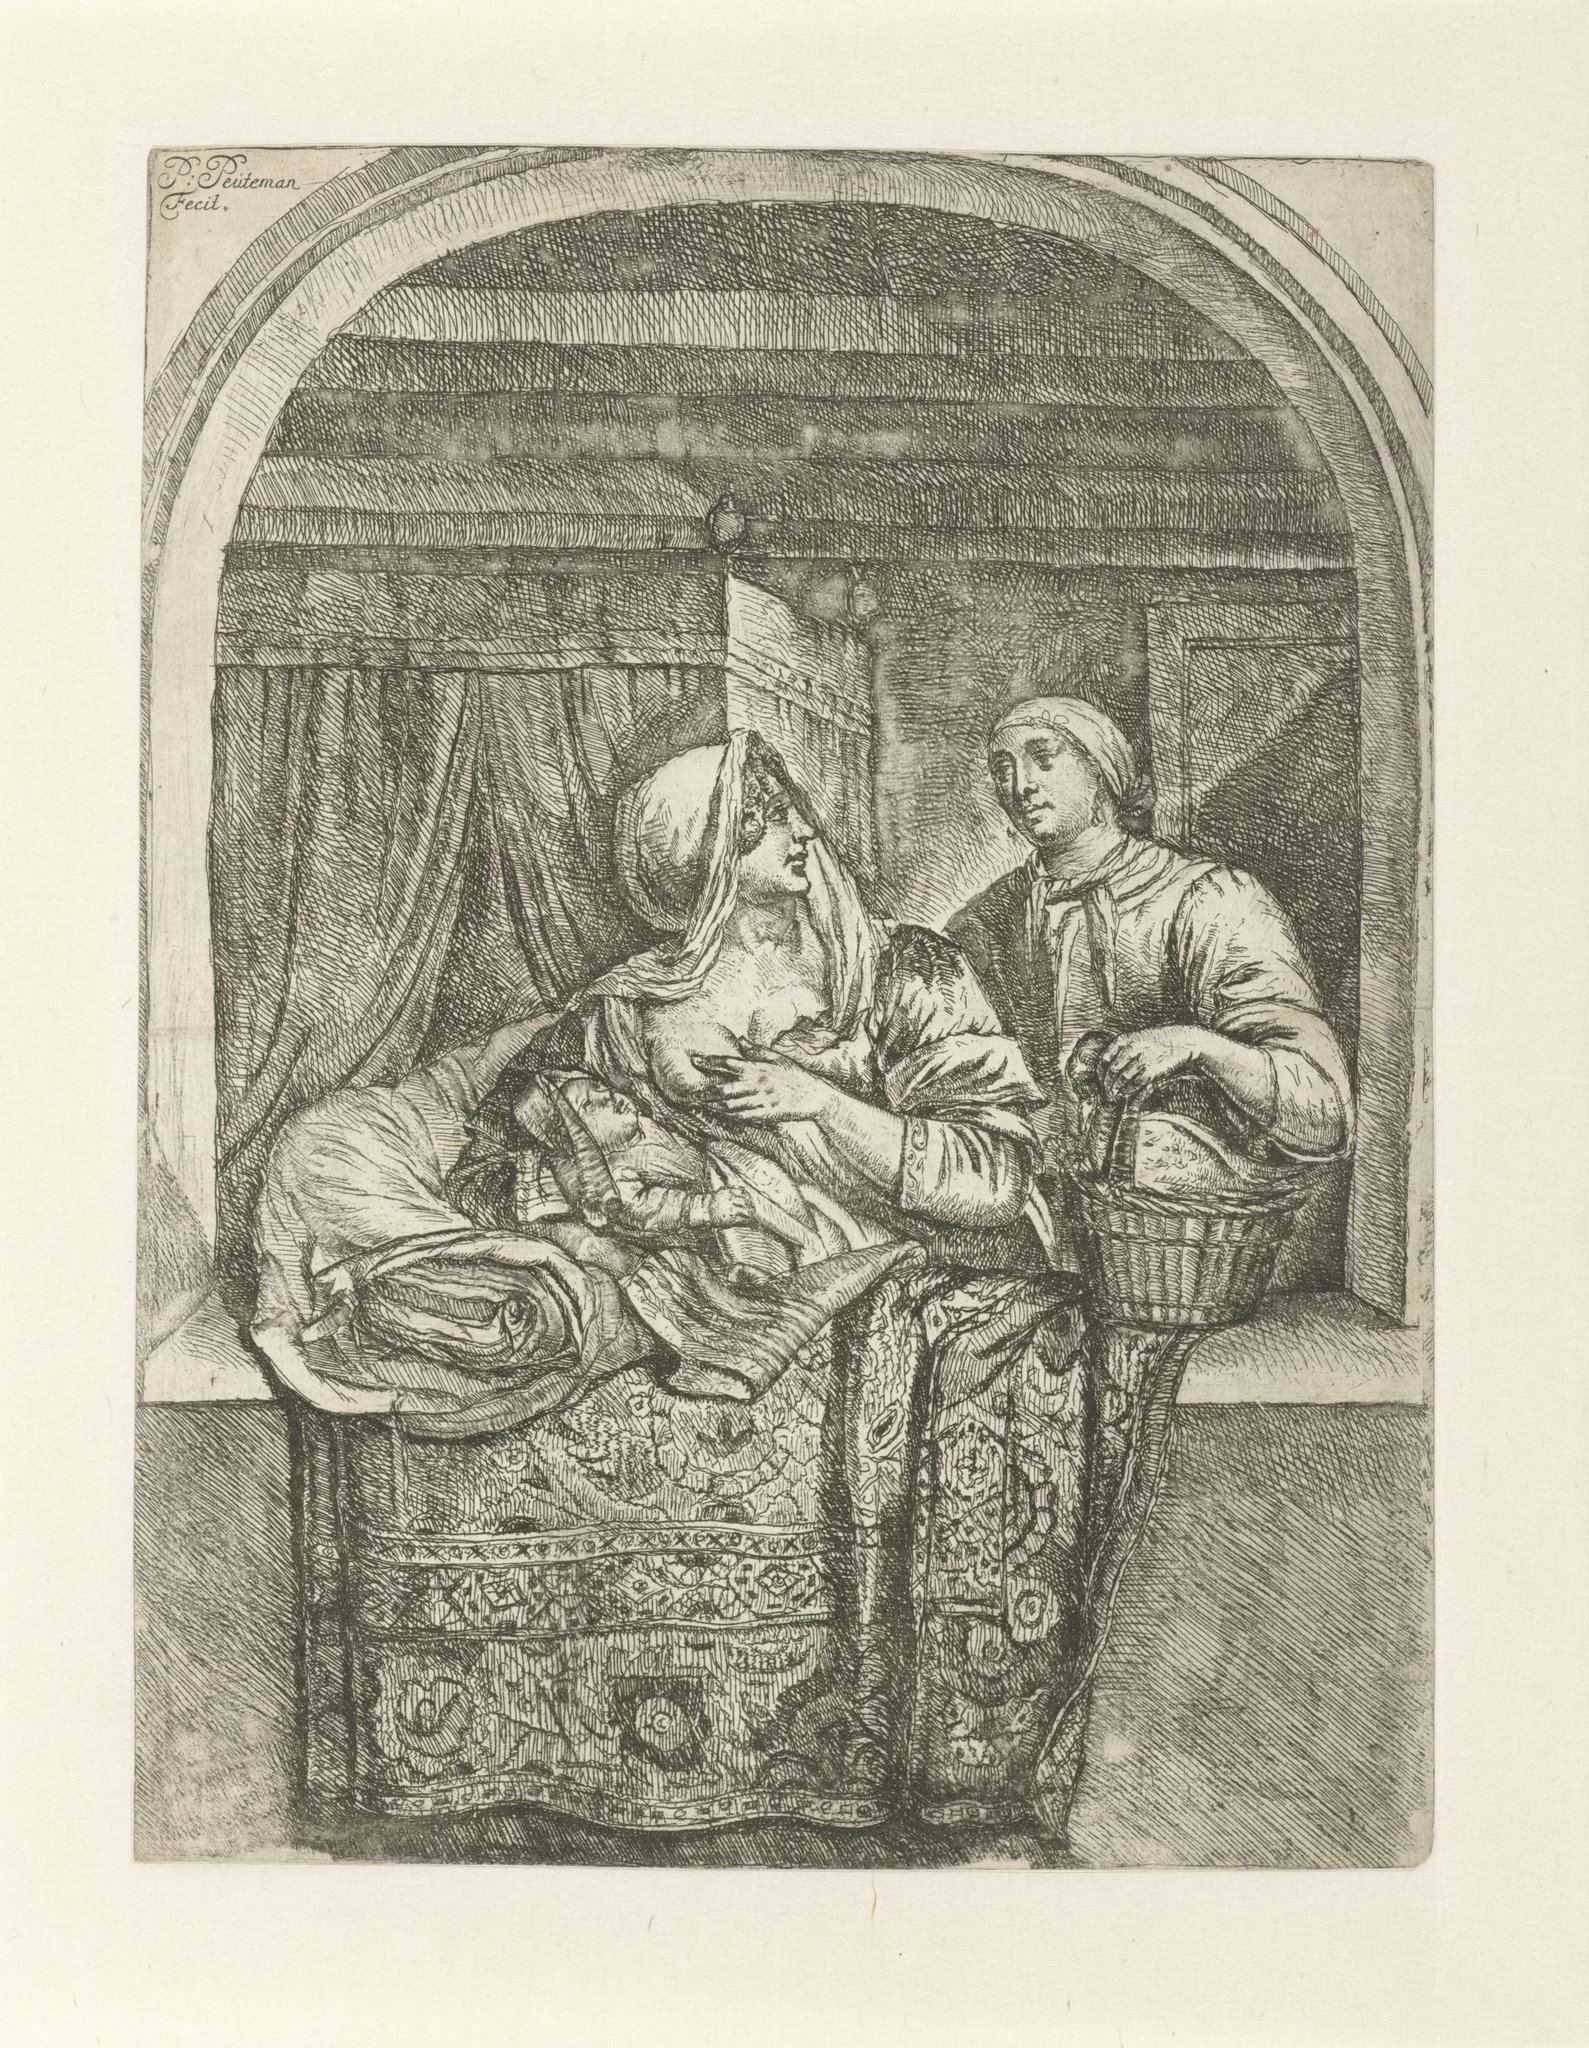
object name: print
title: Vrouw die haar kind de borst geeft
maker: pieter peutemans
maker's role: print maker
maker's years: 1641-1698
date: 1656-1698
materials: paper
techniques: etching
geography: netherlands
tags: nursing, suckling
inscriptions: collector's mark: Lugt 2228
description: Venster waarin een vrouw die haar kind de borst geeft. Achter haar een dienstmeid met een mand waarin een eend.